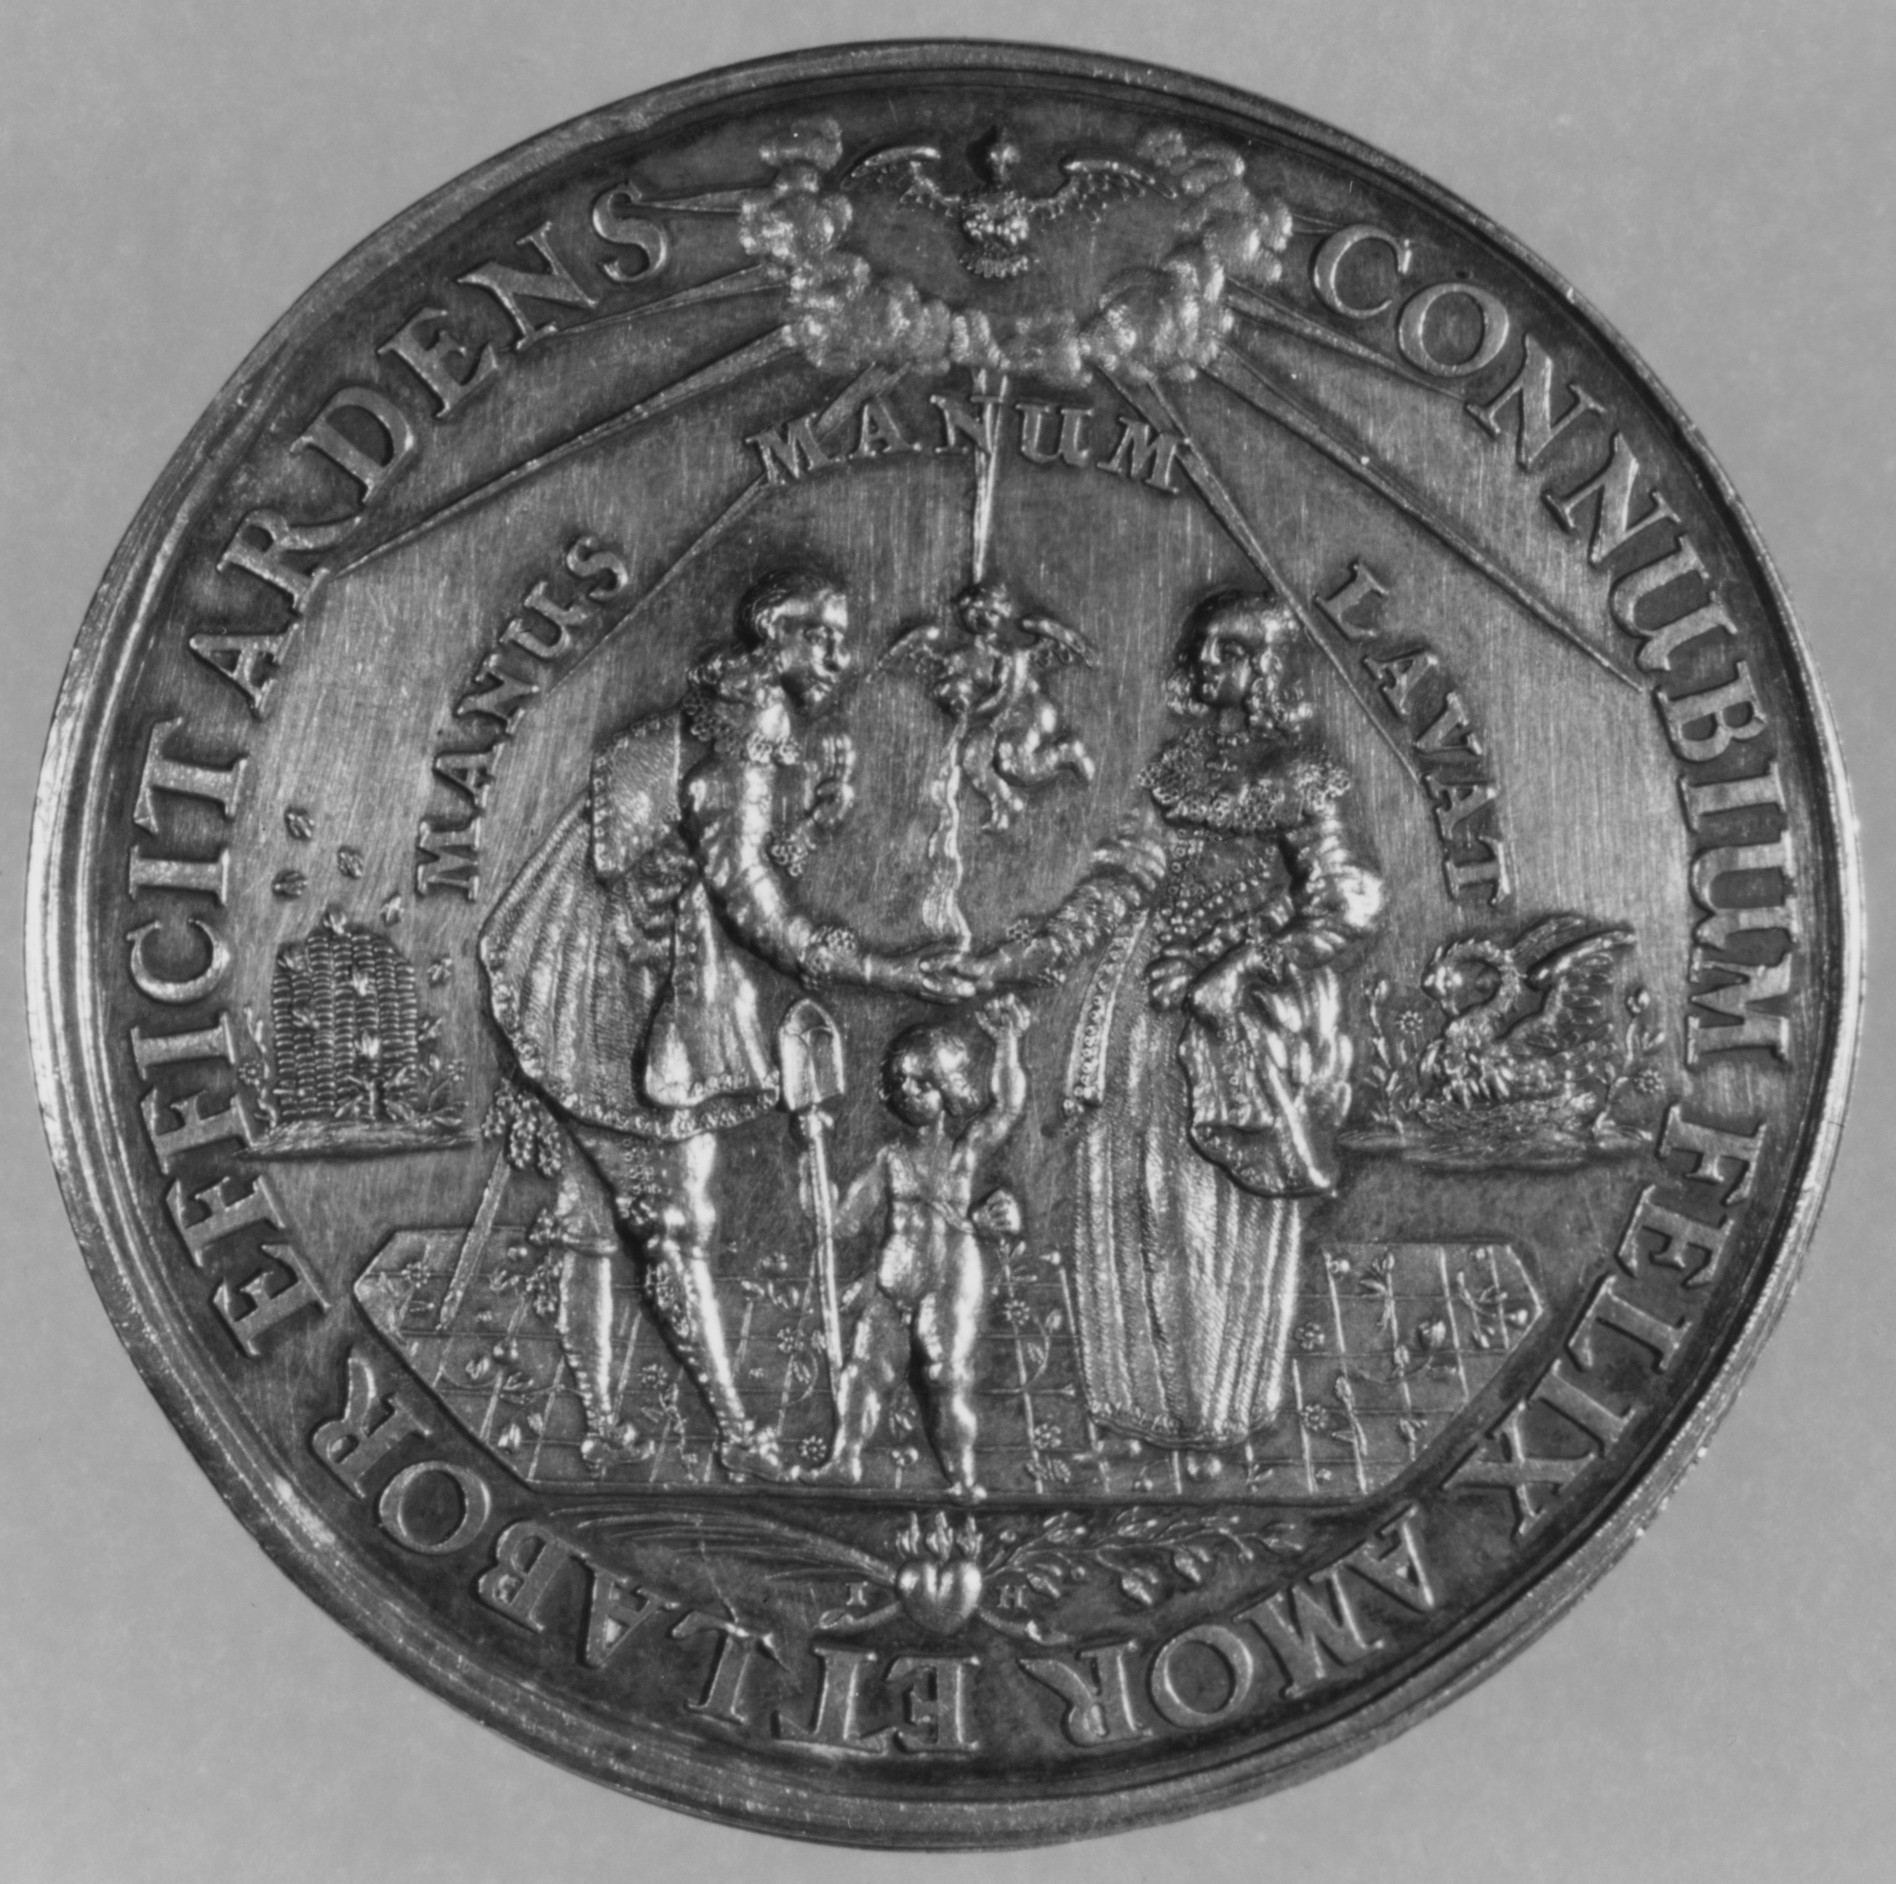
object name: medal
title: Marriage medal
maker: johann höhn i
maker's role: artist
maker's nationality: german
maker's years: 1607-1663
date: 1634-1666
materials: silver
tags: birds,boys,men,women